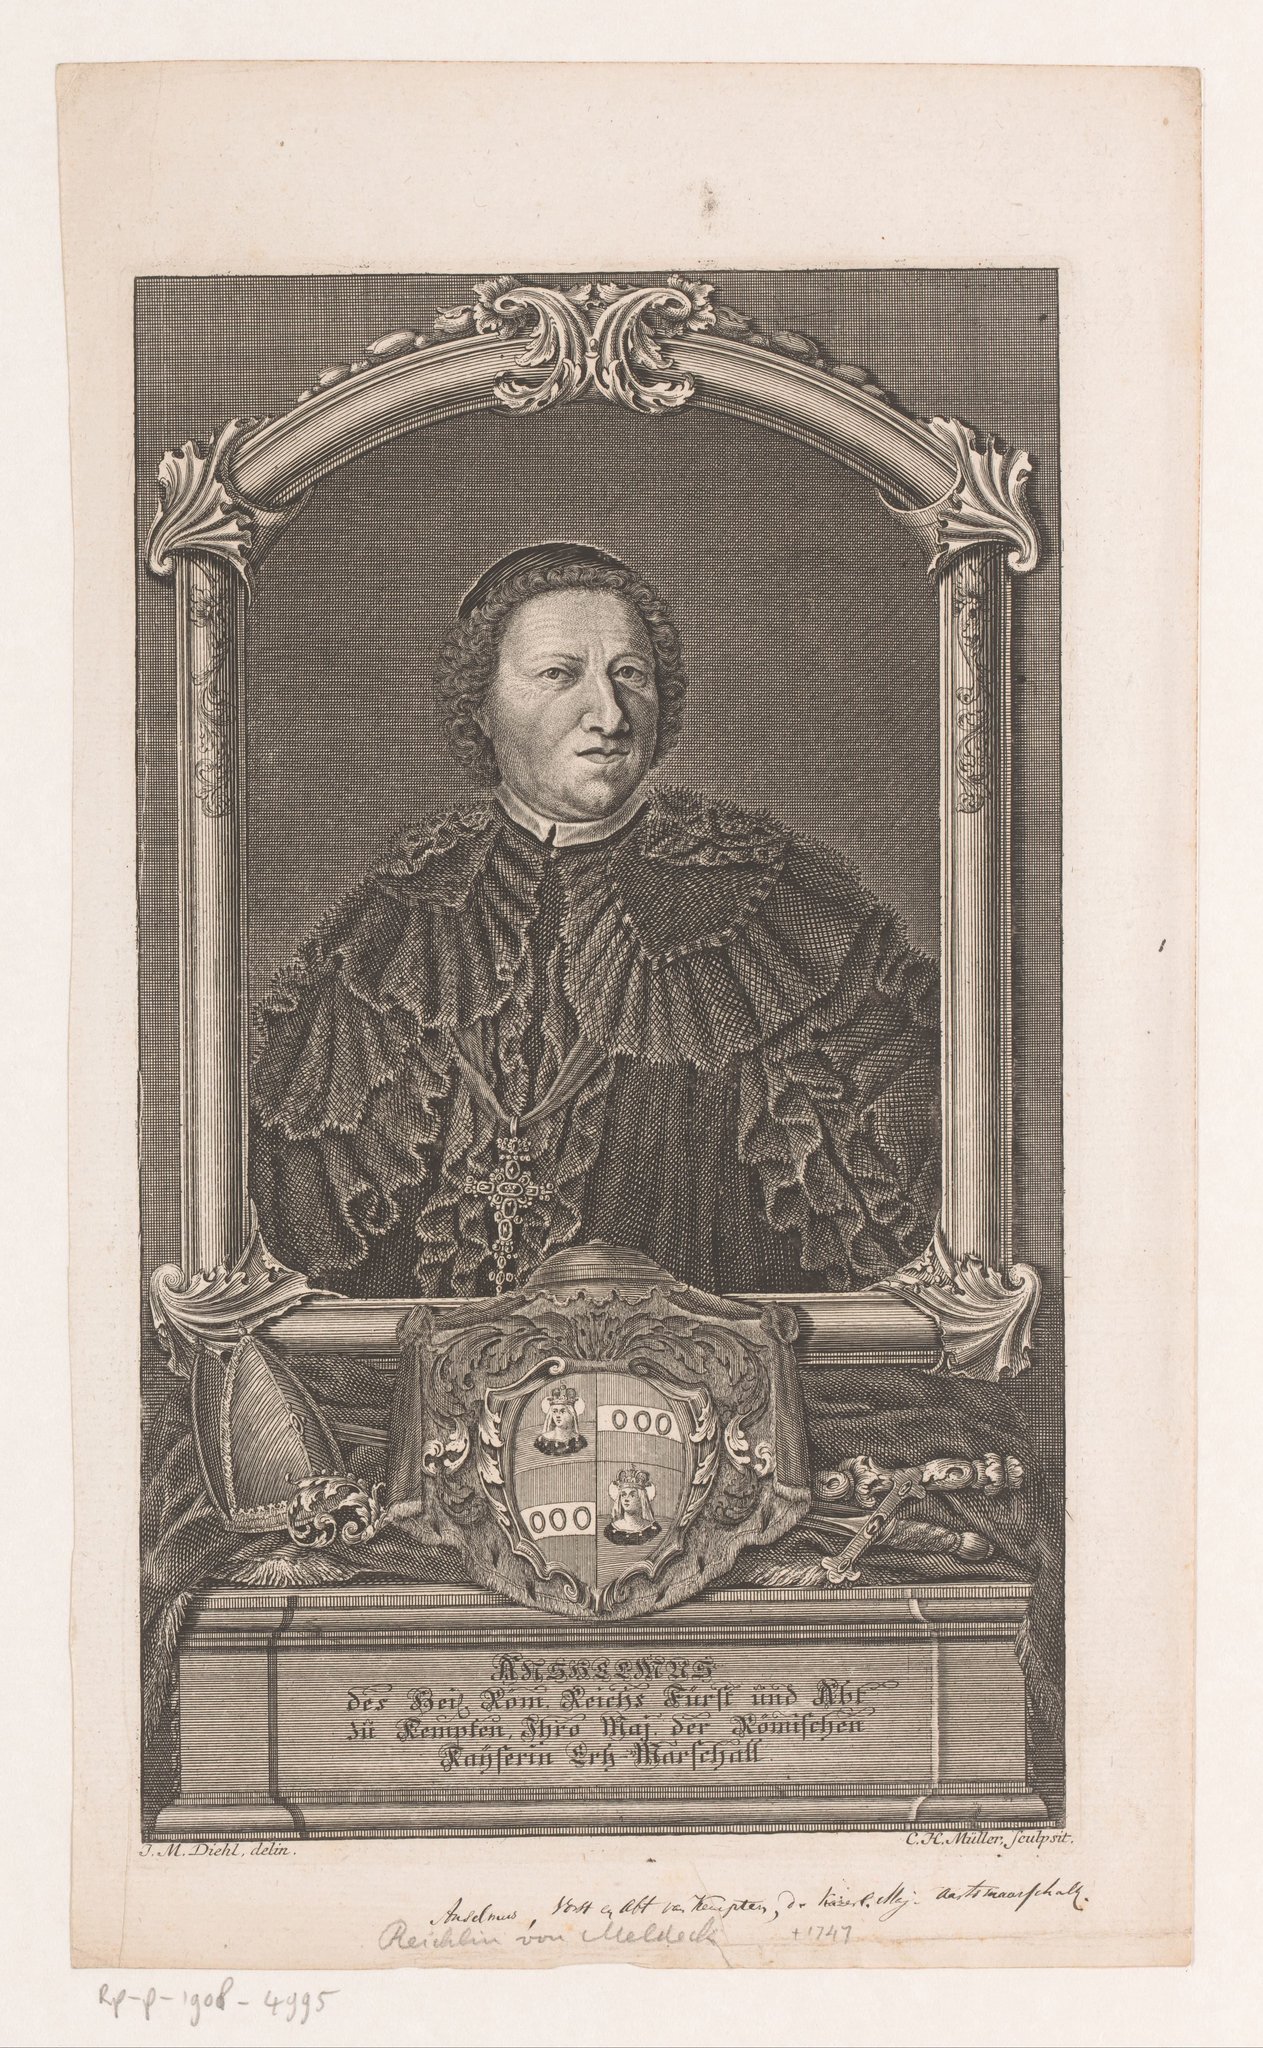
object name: print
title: Portret van Anselm Reichlin von Meldegg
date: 1728-1799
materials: paper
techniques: engraving, etching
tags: liturgical vestments, canonicals, theologian, historical persons, crucifix ~ personal devotion, armorial bearing, heraldry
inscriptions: collector's mark: Lugt 2228